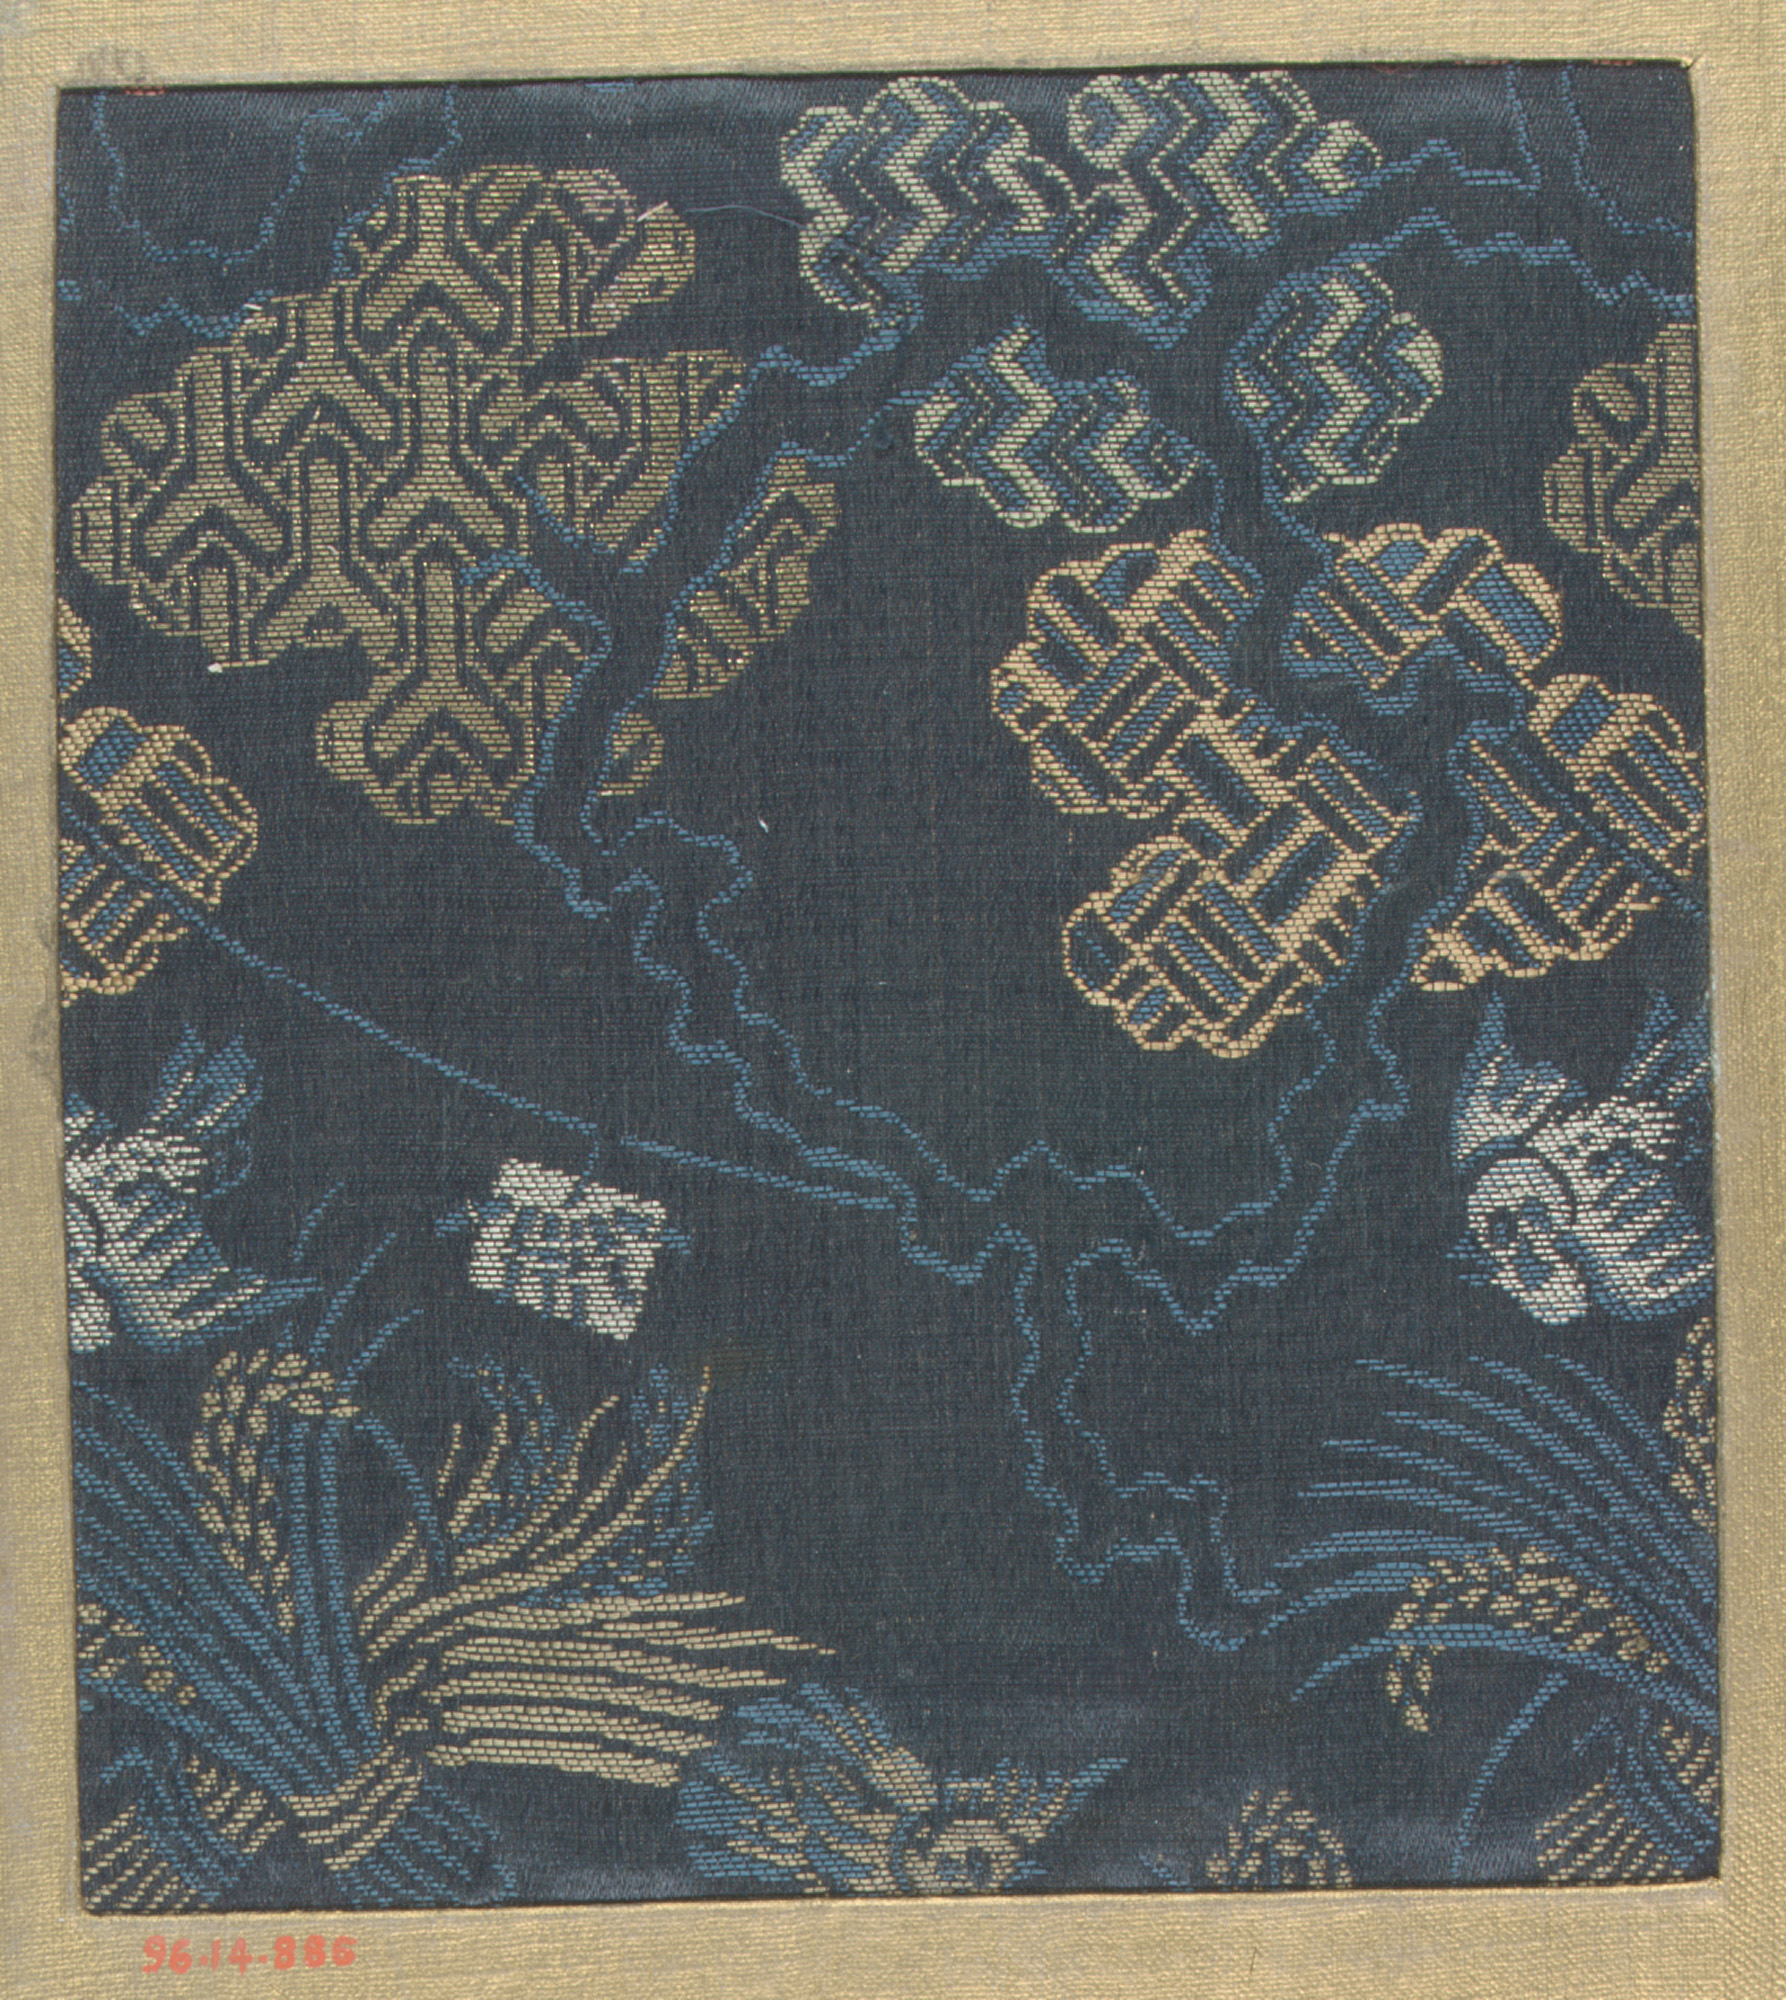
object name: piece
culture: japanese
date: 1701-1900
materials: silk